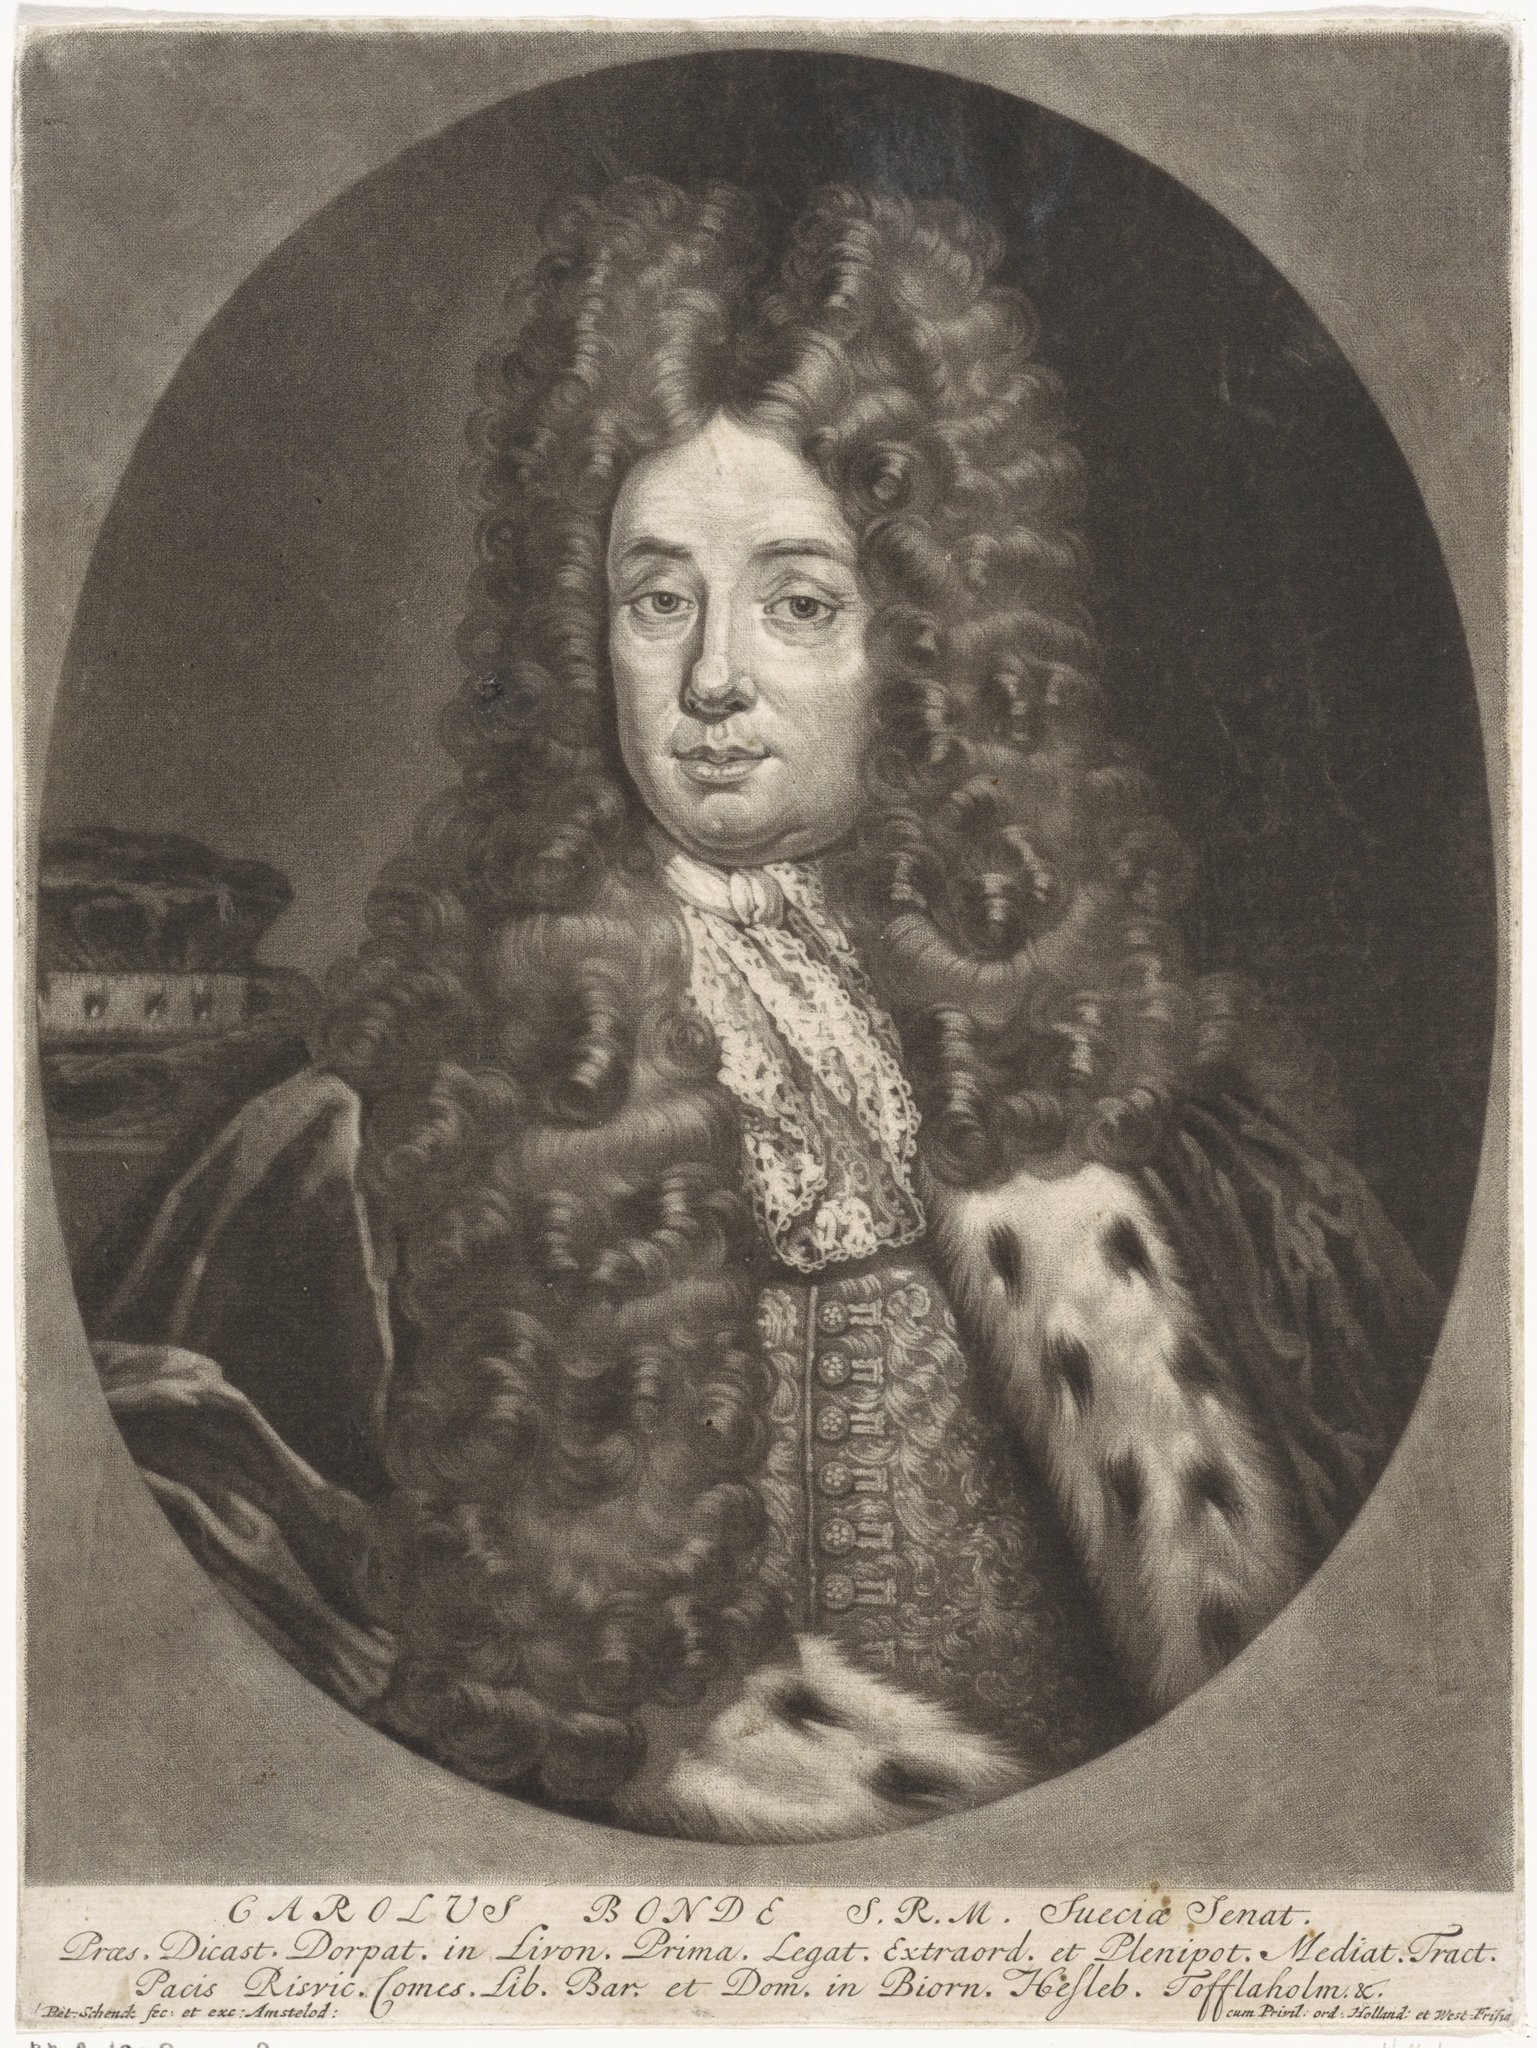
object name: print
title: Portret van Karl von Biorn Bonde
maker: pieter schenk (i)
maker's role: print maker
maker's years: 1660-1711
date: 1670-1713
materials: paper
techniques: engraving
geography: amsterdam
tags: wig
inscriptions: collector's mark: Lugt 2228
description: De Zweedse senator graaf Karl von Biorn Bonde. Hij draagt een lange krulpruik.